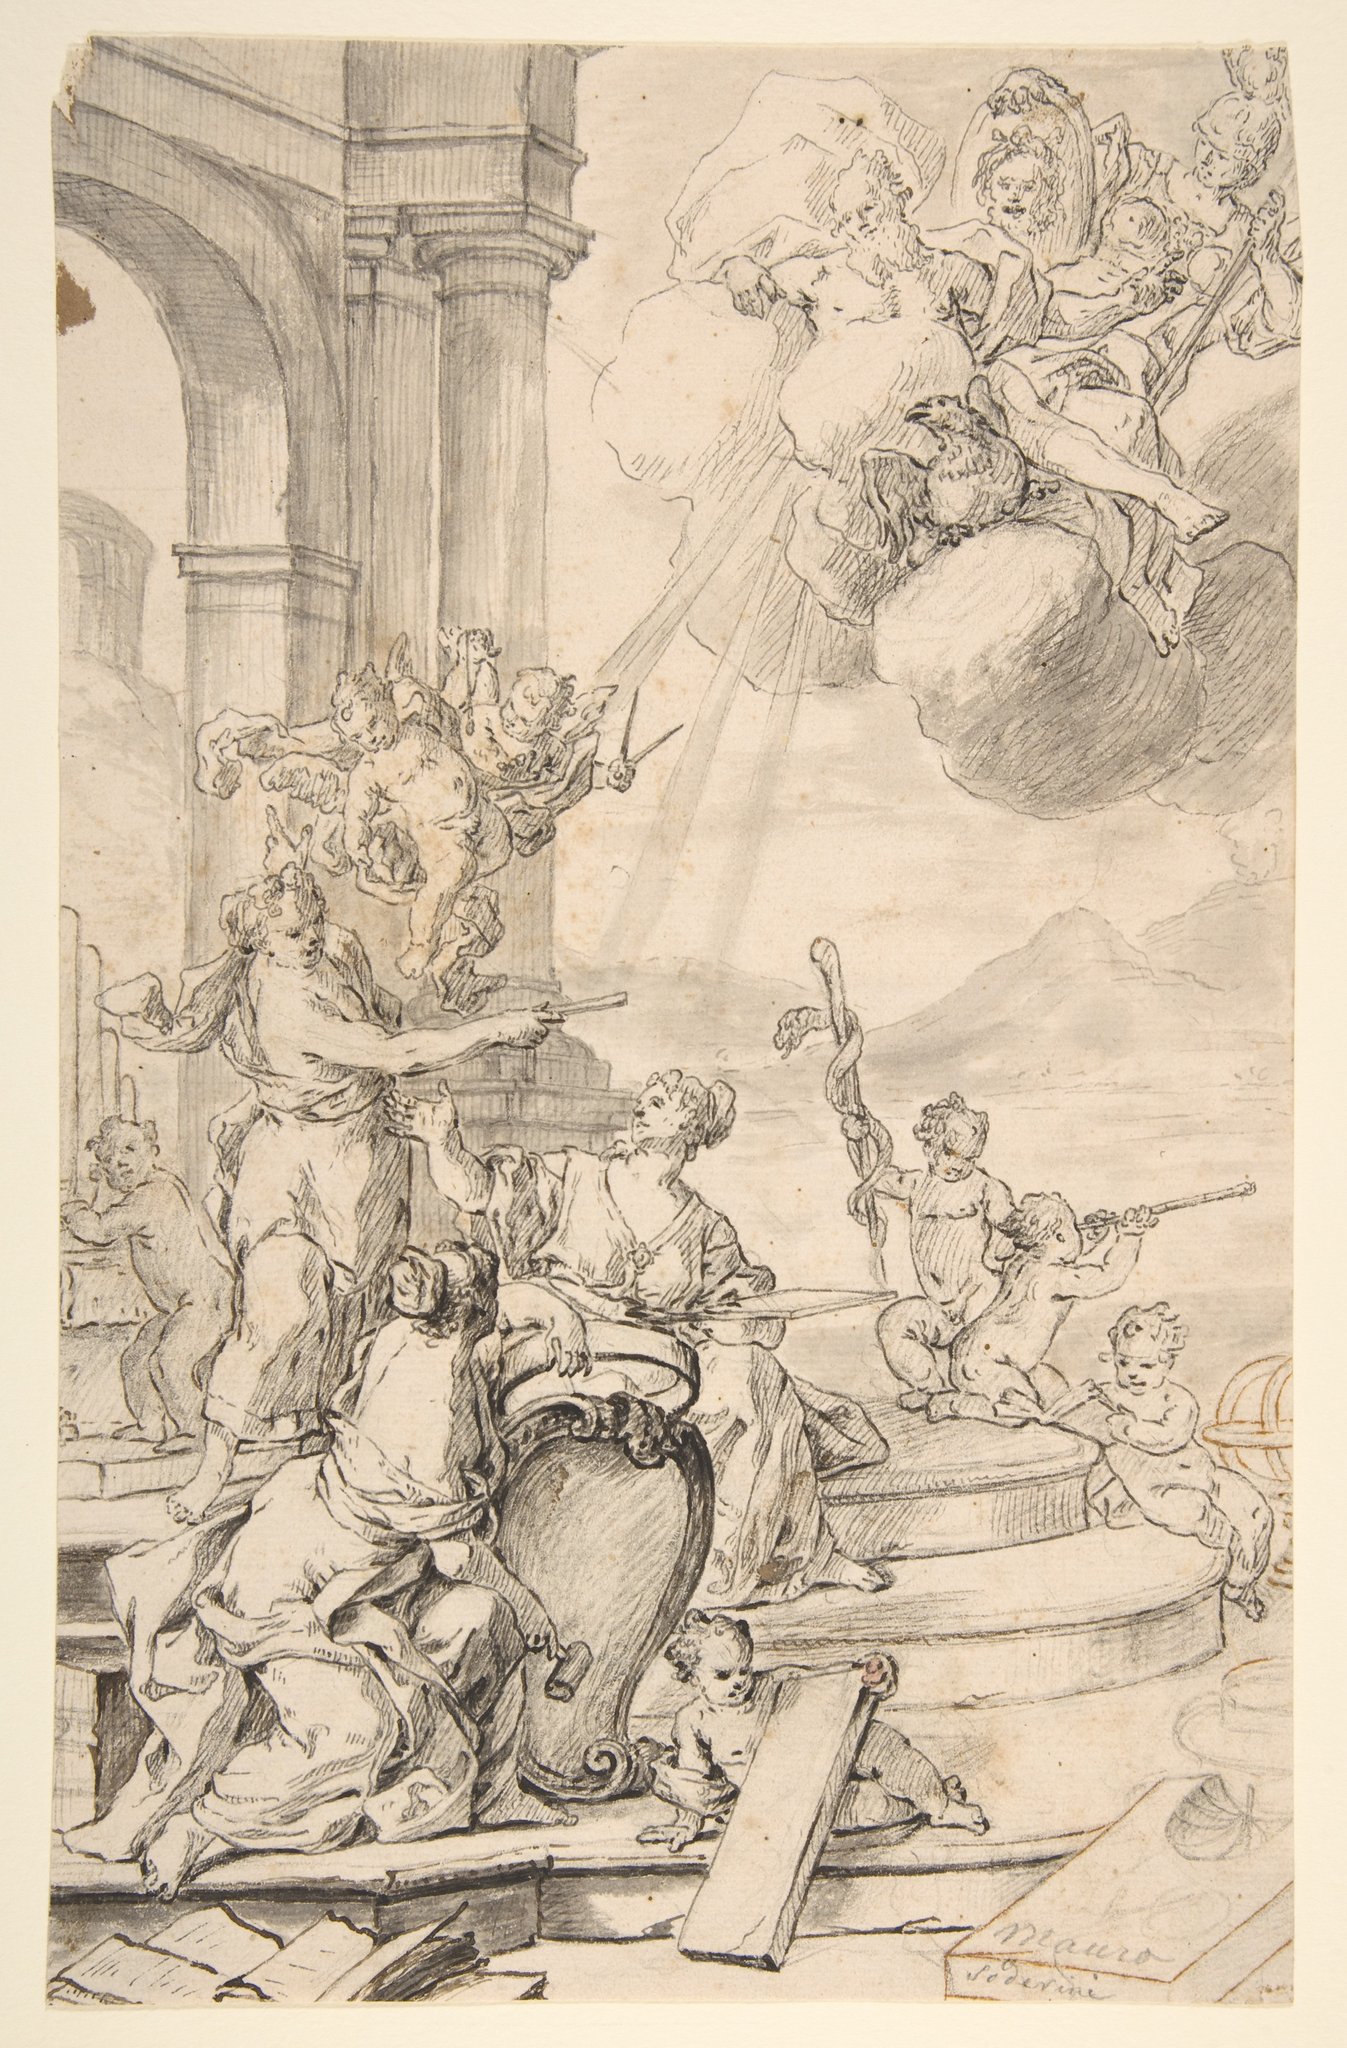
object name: drawing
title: Drawing for a Frontispiece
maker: mauro soderini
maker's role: artist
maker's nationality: italian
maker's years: 1704-1739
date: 1704-1739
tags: cartouches,women,putti